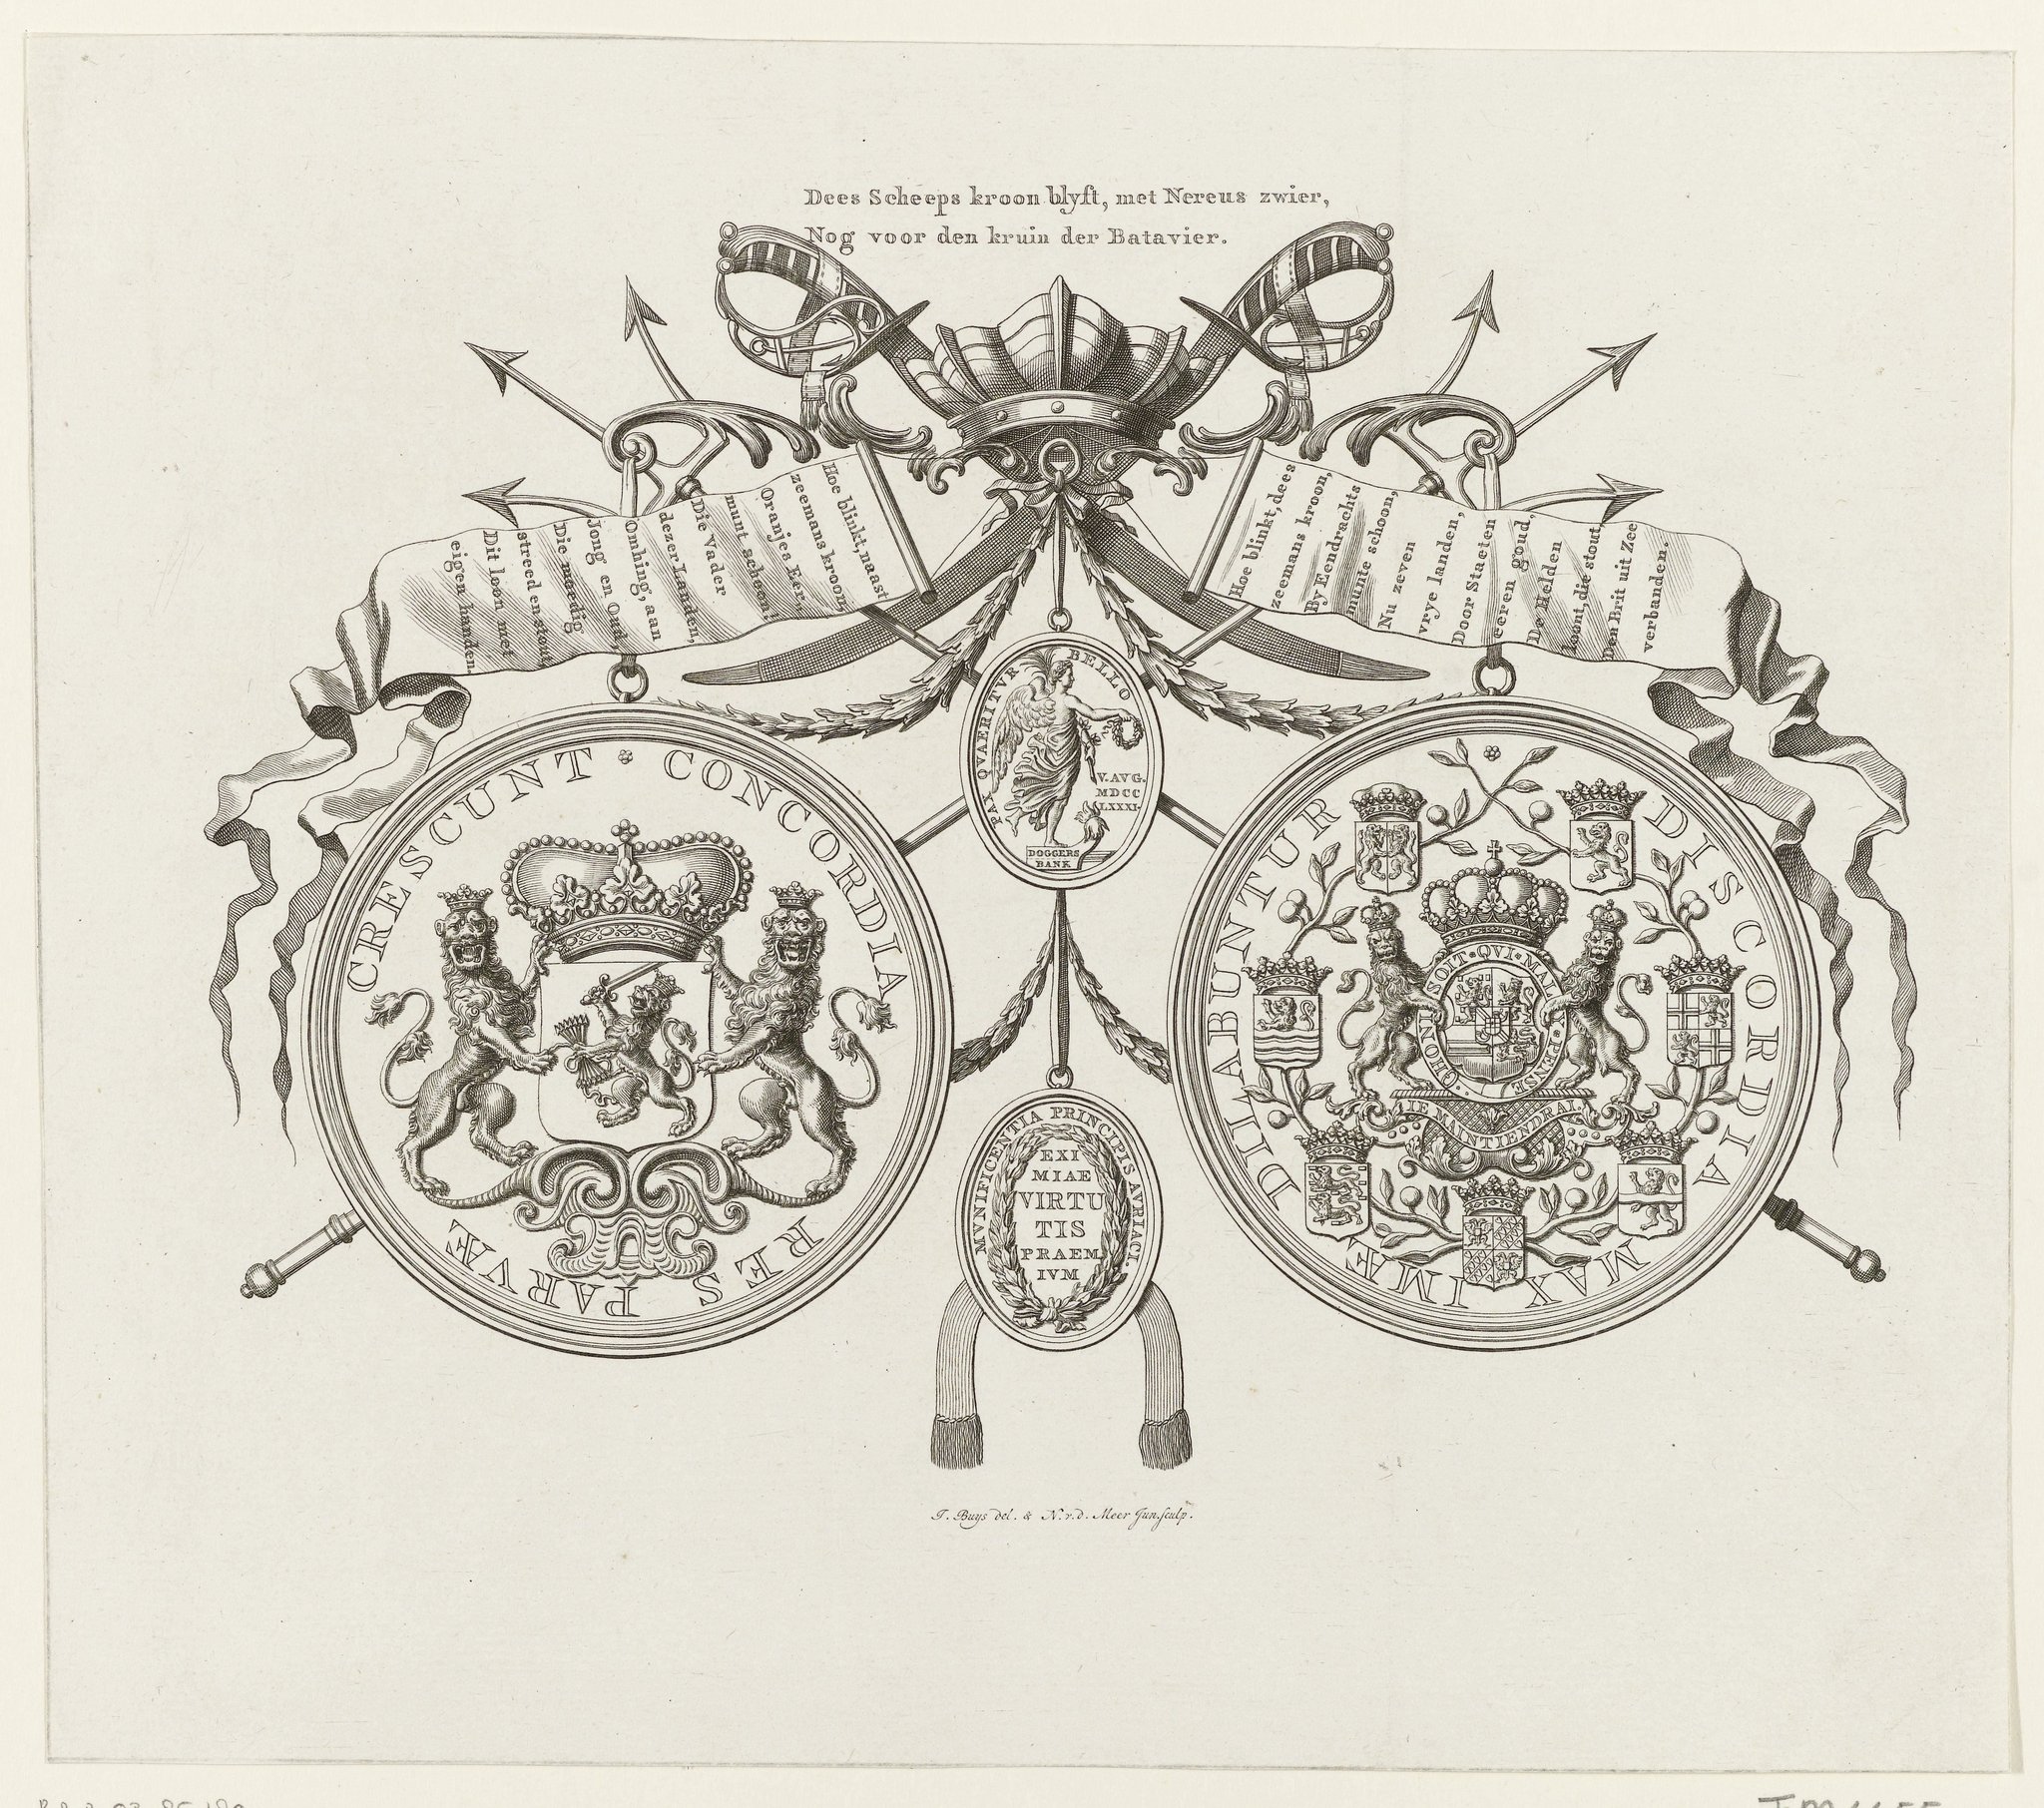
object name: print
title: Gedenkpenning Zeeslag bij Doggersbank, 1781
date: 1781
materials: paper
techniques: engraving, etching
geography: northern netherlands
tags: the hague, johan arnold zoutman, medal (considered as a piece of sculpture, regardless of its specific function)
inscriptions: collector's mark: Lugt 2228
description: Trofee rond de gedenkpenning door de Staten-Generaal aangeboden op 30 november aan schout-bij-nacht Johan Zoutman en medestrijders na de overwinning in de zeeslag bij Doggersbank op 5 augustus 1781.